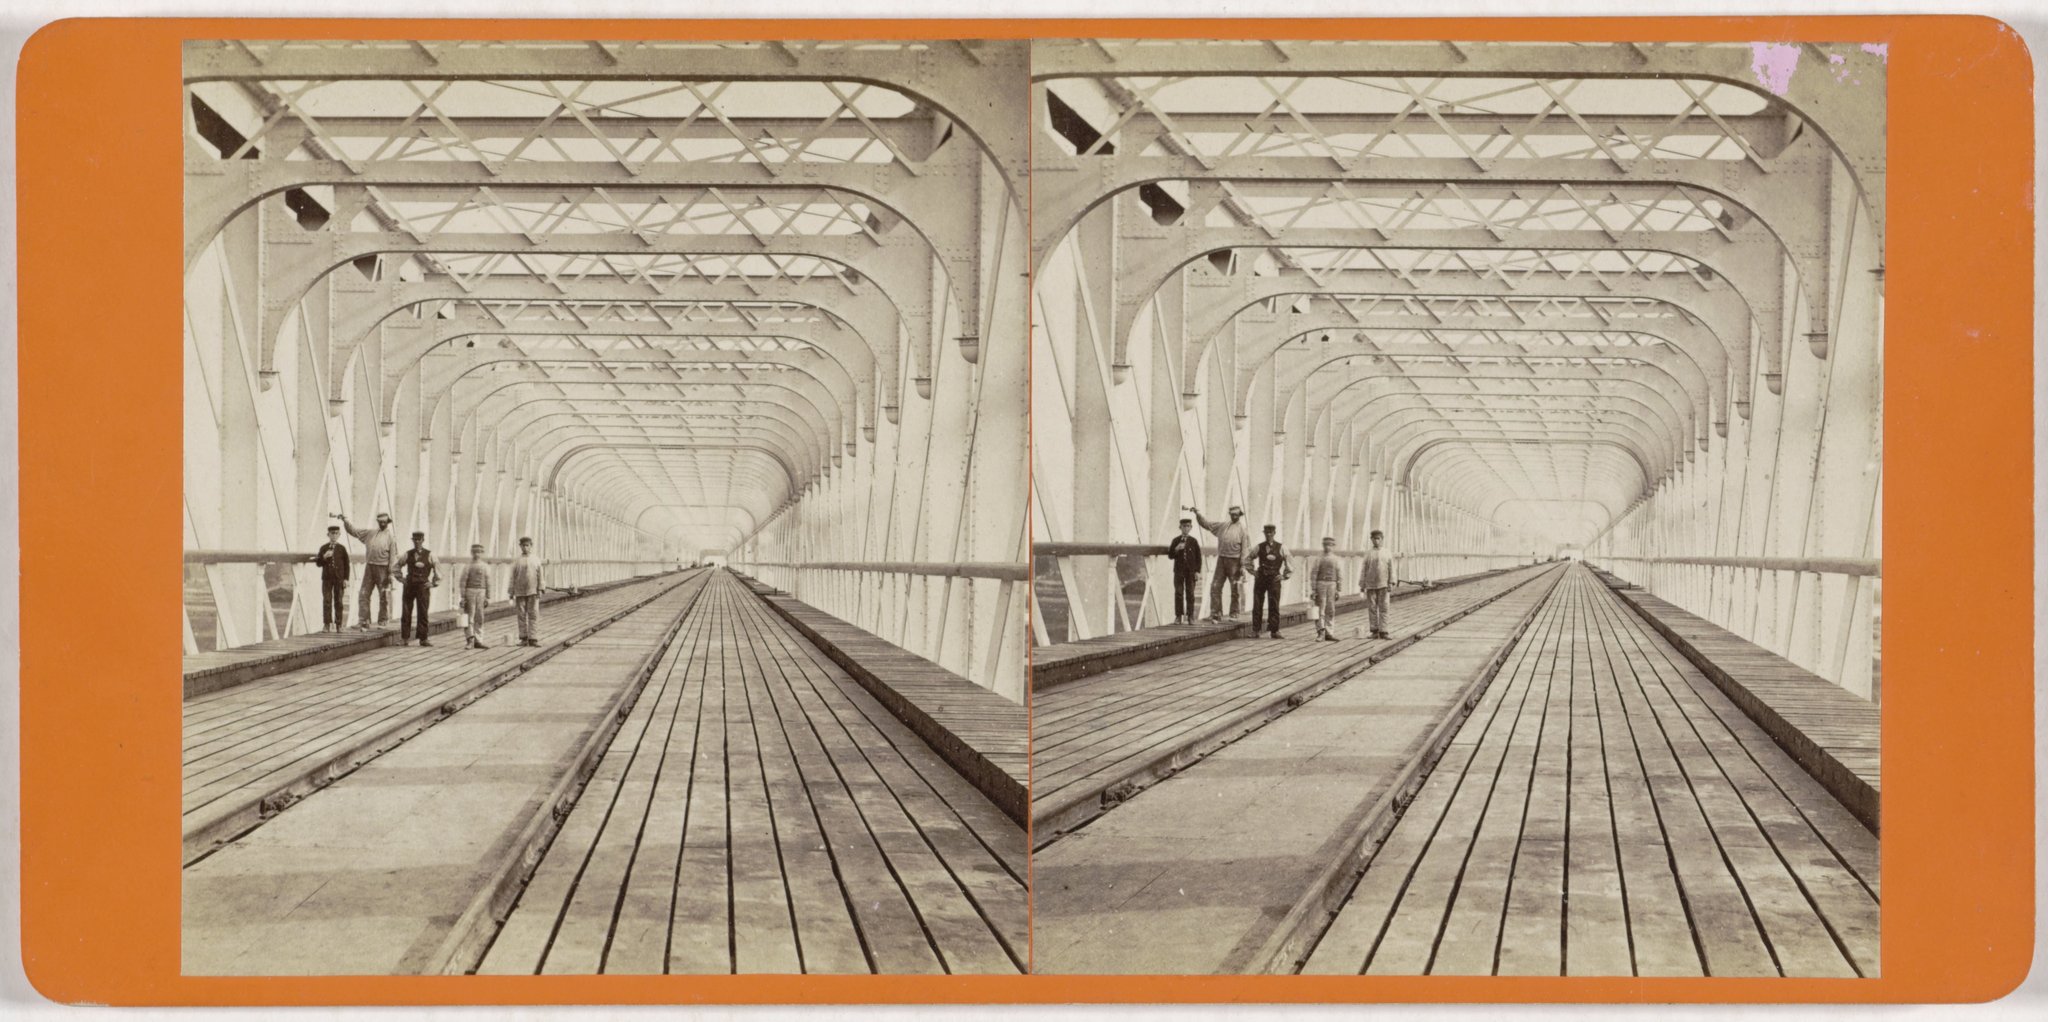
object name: stereograph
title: Kuilenburgse spoorbrug over de Lek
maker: pieter oosterhuis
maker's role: draughtsman, print maker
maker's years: 1816-1885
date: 1868-1885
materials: cardboard, paper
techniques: albumen print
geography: culemborg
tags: bridge in village across river, canal, etc. - ii - ideal landscapes